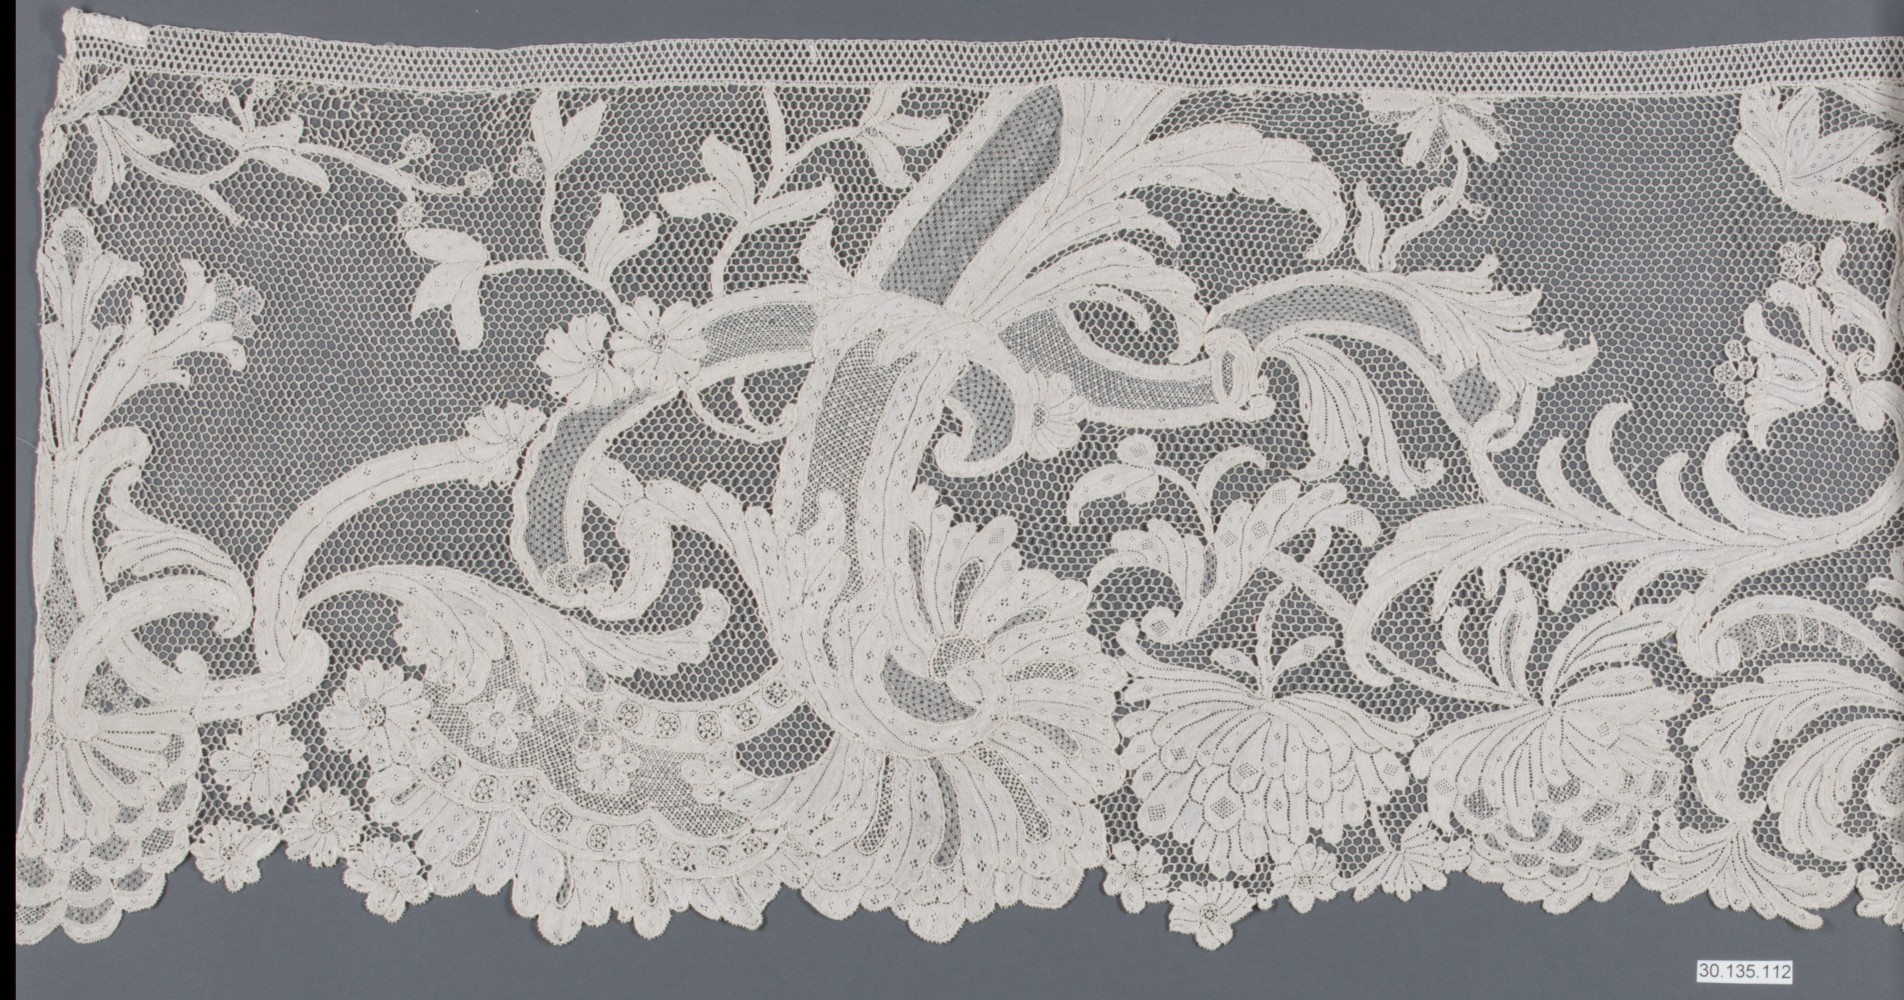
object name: flounce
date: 1715-1723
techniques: lace